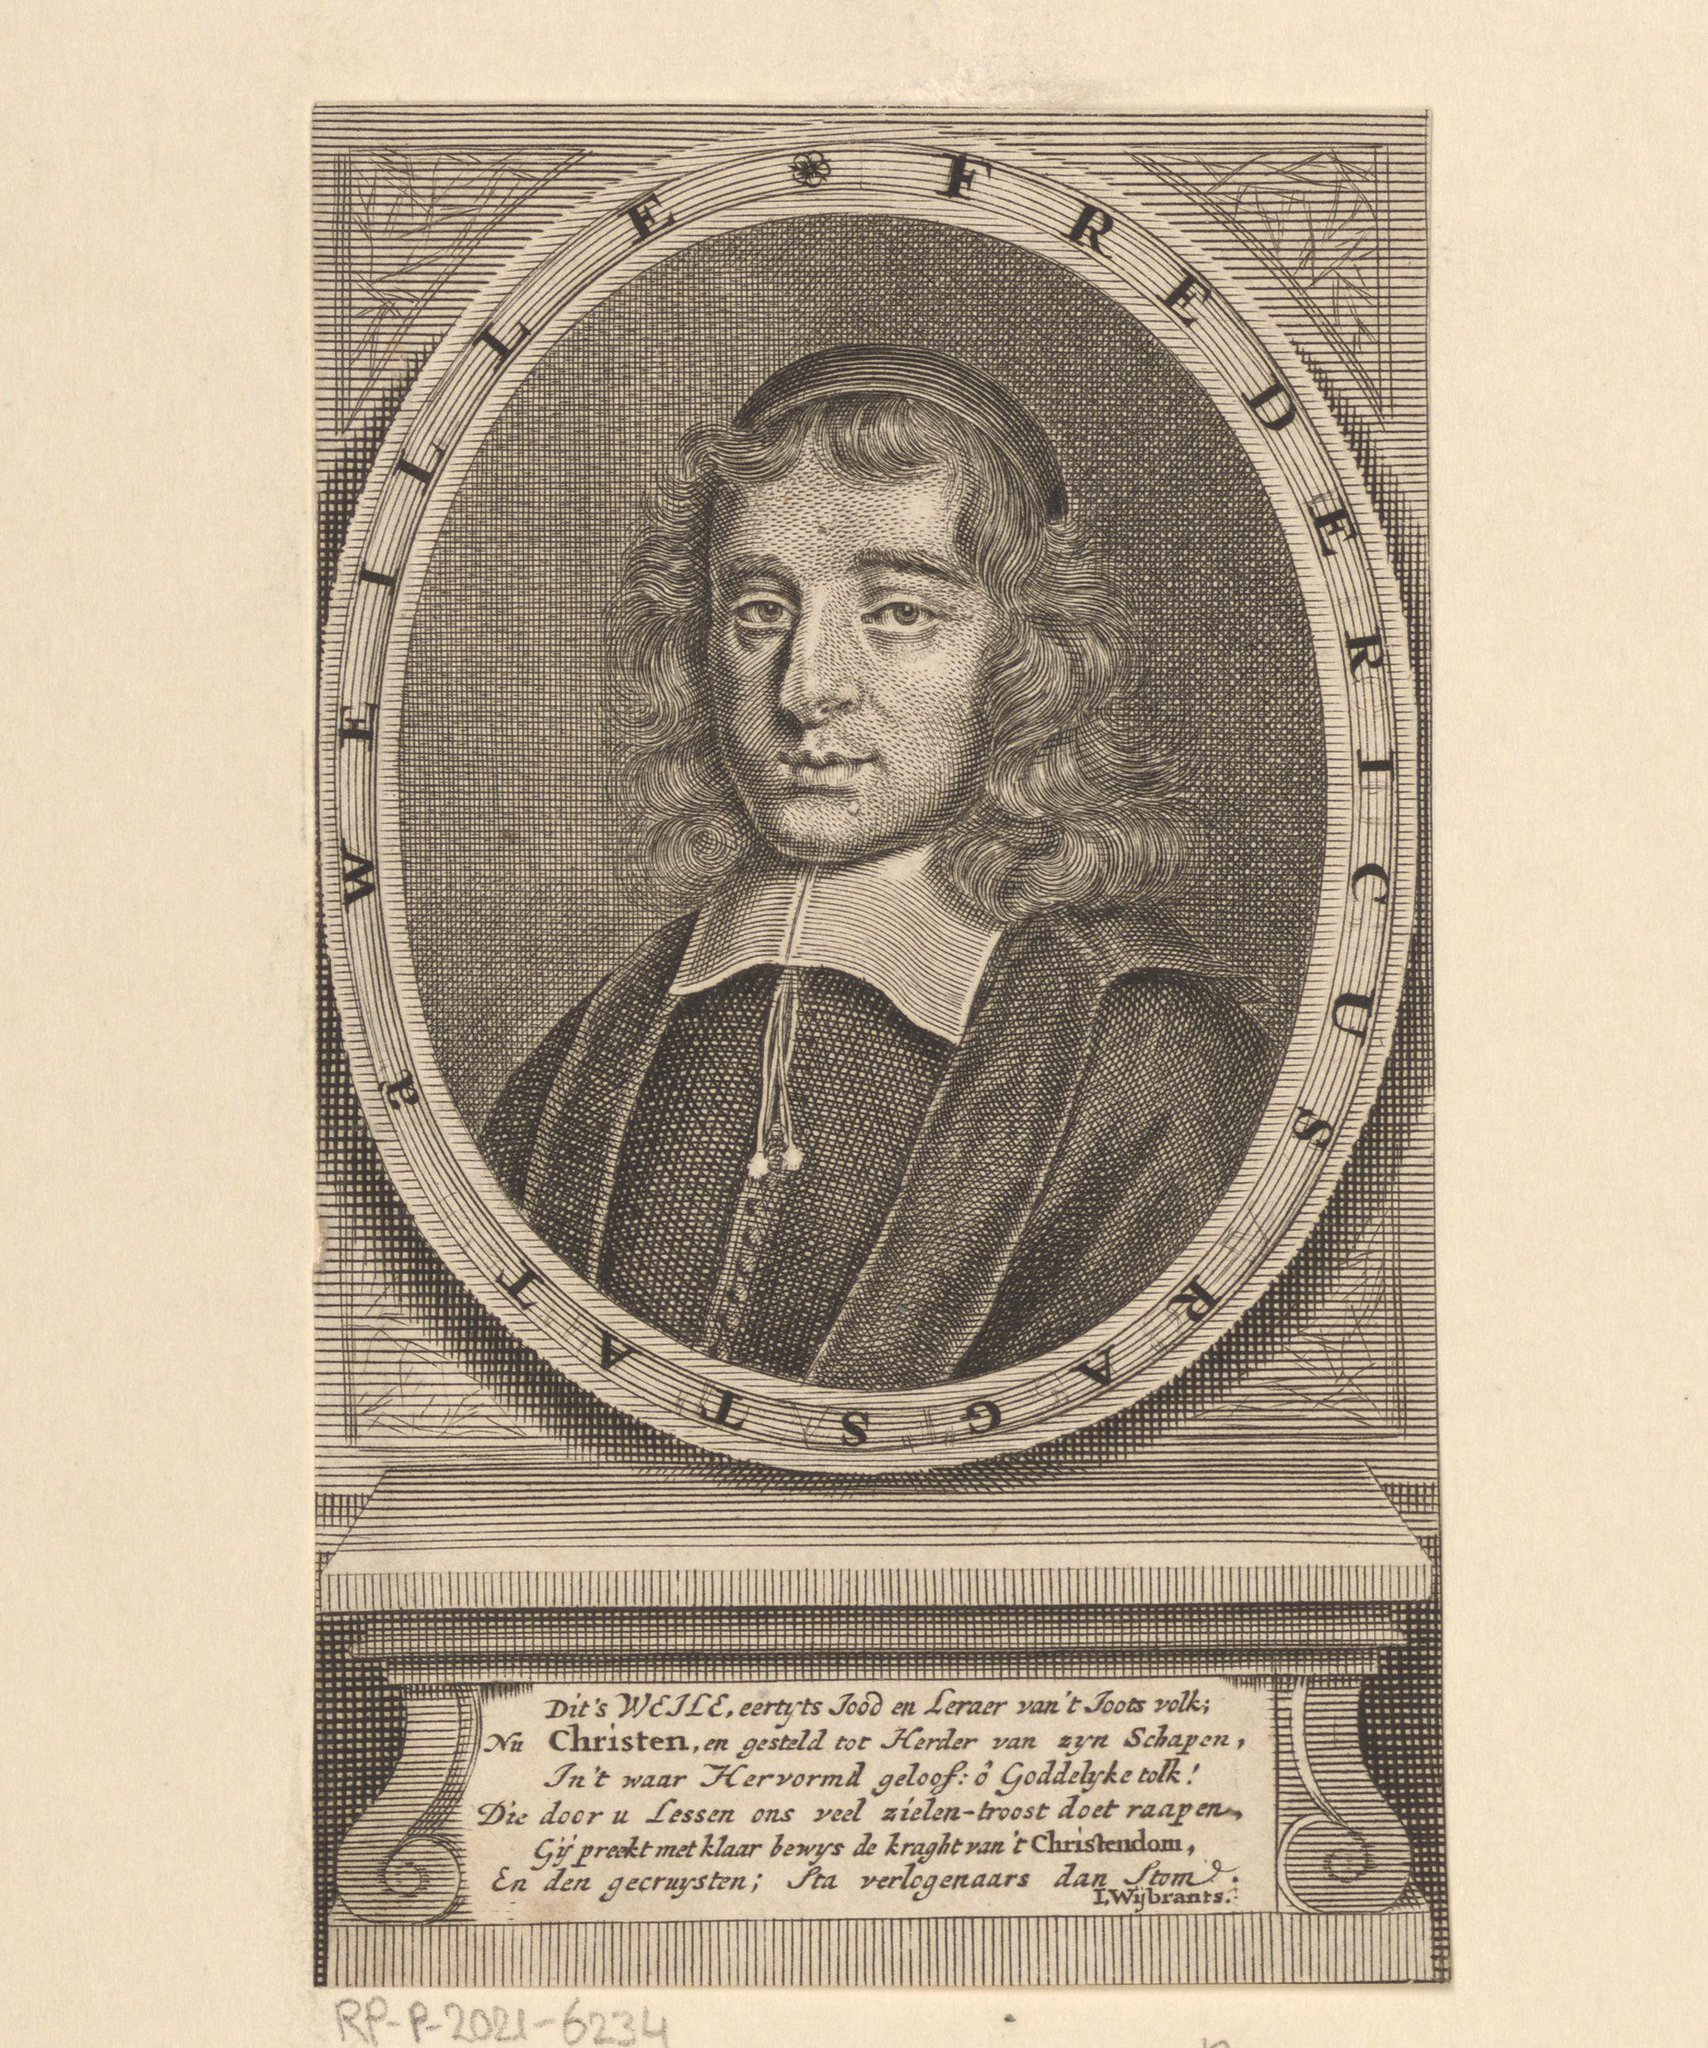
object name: print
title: Portret van Friedrich Ragstat von Weile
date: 1720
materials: paper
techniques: engraving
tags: historical persons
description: Prent mogelijk uit: Weile, Friedrich Ragstat von. Klaar en duidelyk vertoog; volgens d'aanbiddelyke huishoudinge Gods (...). Den Haag: Pieter van der Burg, 1720.